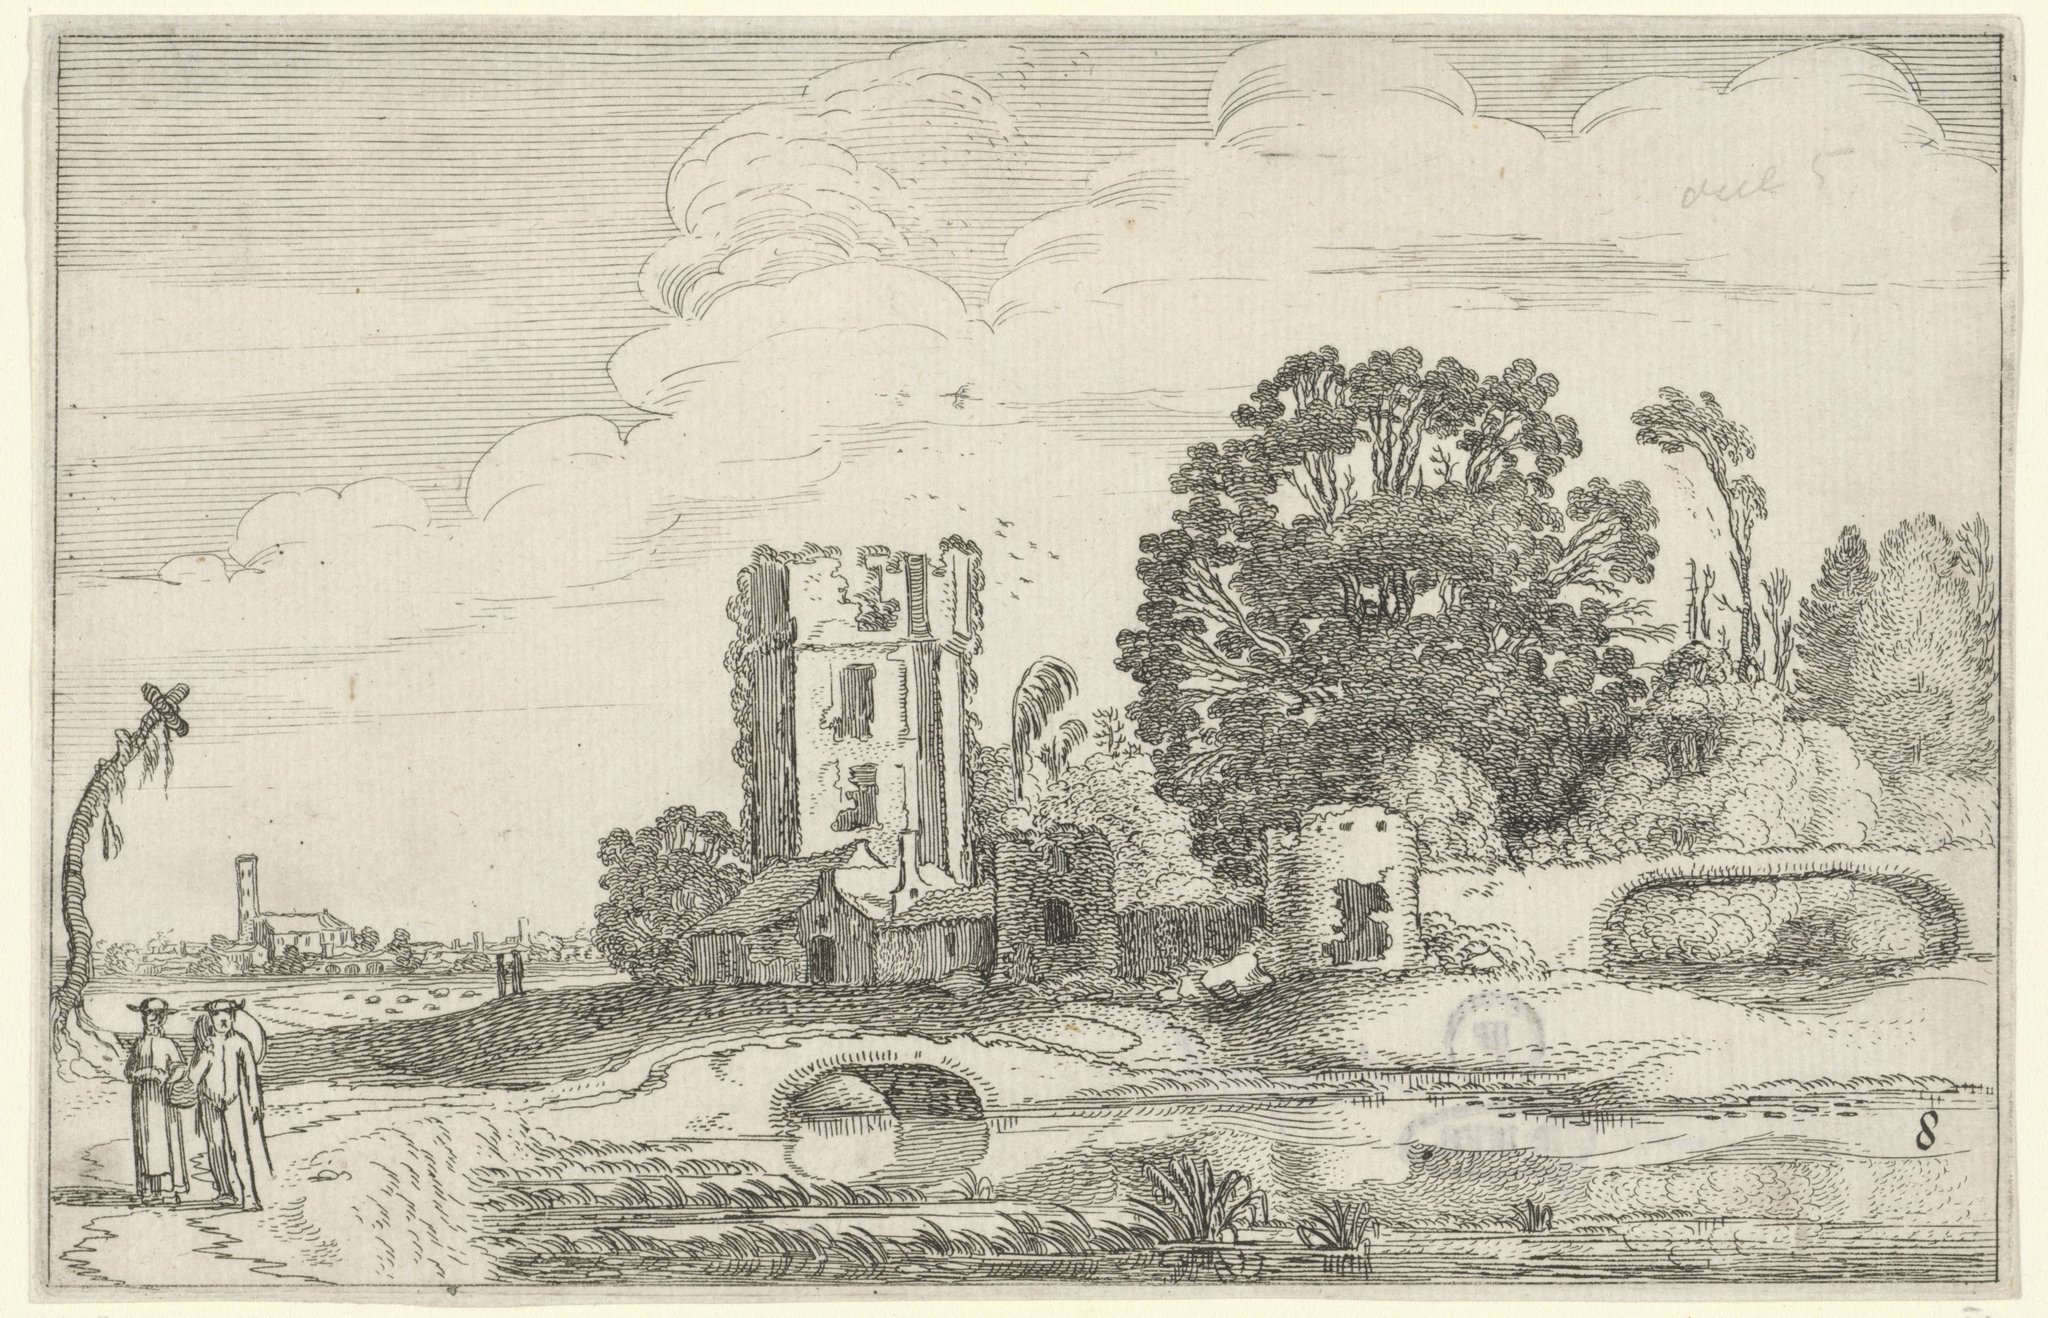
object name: print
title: Amenissimae aliquot requculae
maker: jan van de velde (ii)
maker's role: draughtsman, painter, print maker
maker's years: 1593-1641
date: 1616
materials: paper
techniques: etching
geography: northern netherlands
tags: landscape with bridge, viaduct or aqueduct, landscape with ruins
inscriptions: collector's mark: Lugt 964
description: Gezicht op de toren van Huis ter Kleef, te Haarlem. Links twee figuren op een pad. Achtste prent van deel vijf van een serie van in totaal zestig prenten met landschappen, verdeeld over vijf delen van elk twaalf prenten.